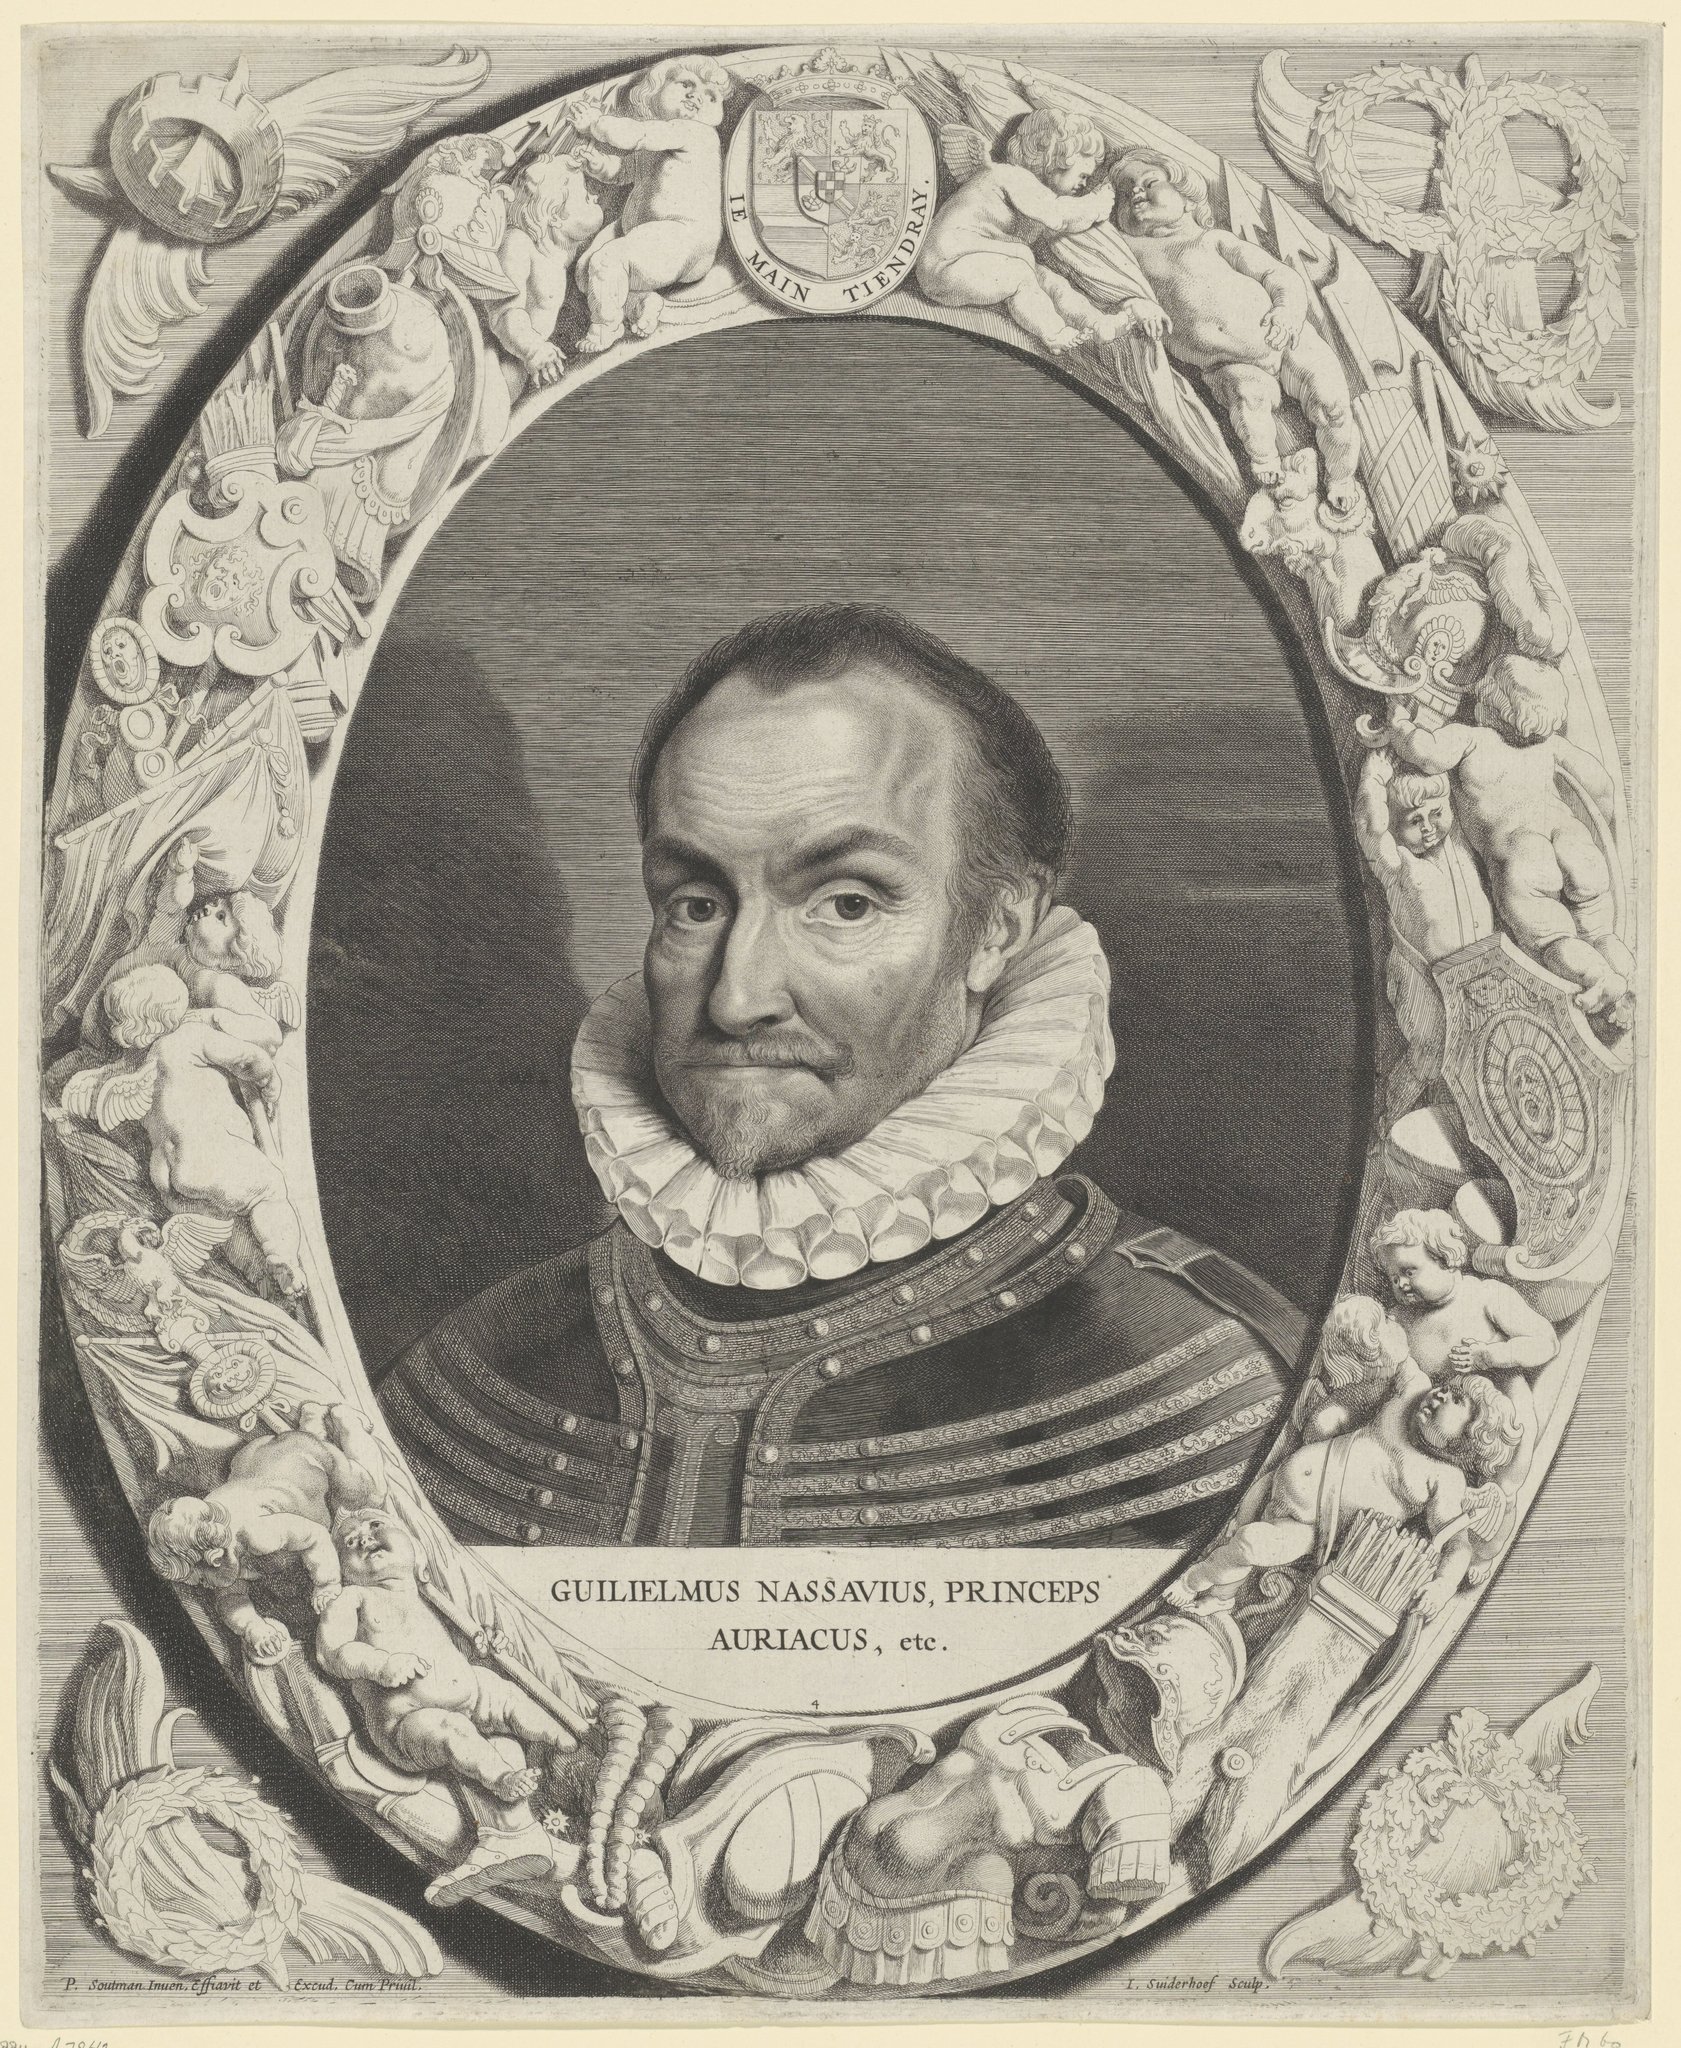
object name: print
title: Portret van Willem I, prins van Oranje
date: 1643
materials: paper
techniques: engraving, etching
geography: haarlem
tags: delft, william i (prince of orange), 'tropaion', i.e. decorative ornament ~ weapons, cupids: 'amores', 'amoretti', 'putti'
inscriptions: collector's mark: Lugt 2228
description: De hier vermelde titel verwijst naar de hoogst verkregen titel van de geportretteerde, niet per se naar de titel die de geportretteerde op deze voorstelling draagt.